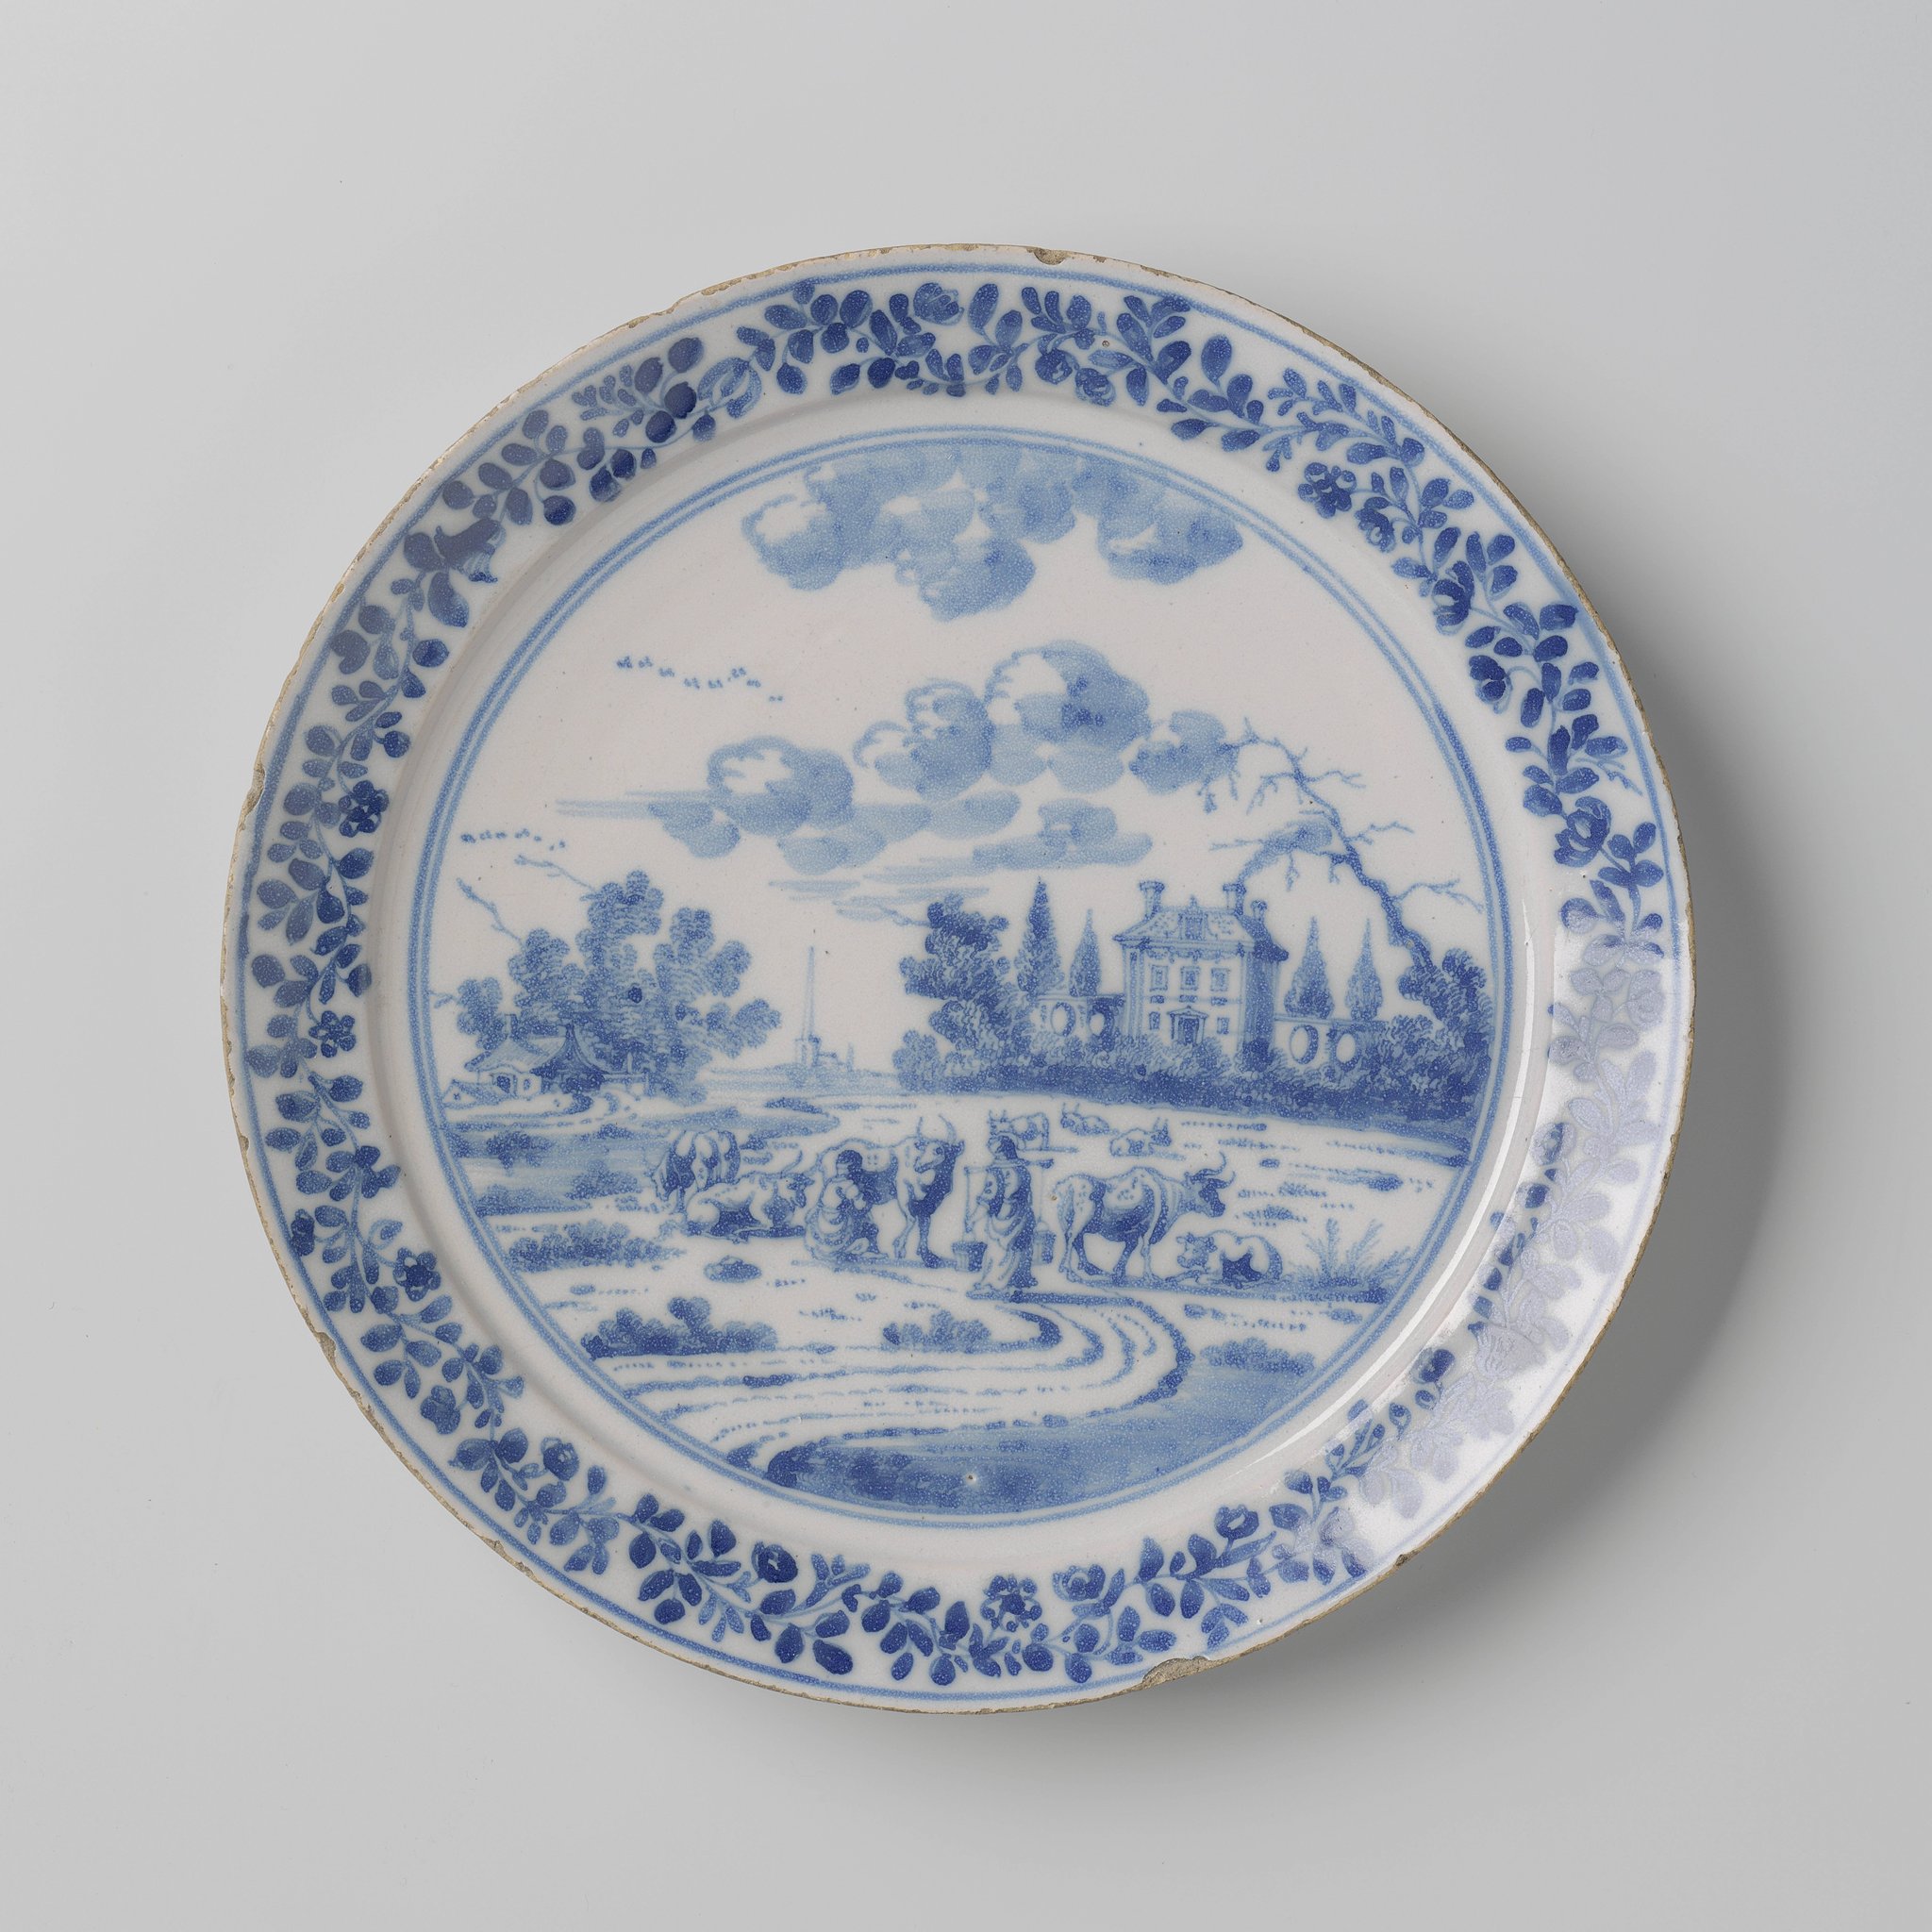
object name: plate dish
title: Bord van faience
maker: Anonymous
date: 1710-1735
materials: faience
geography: amsterdam